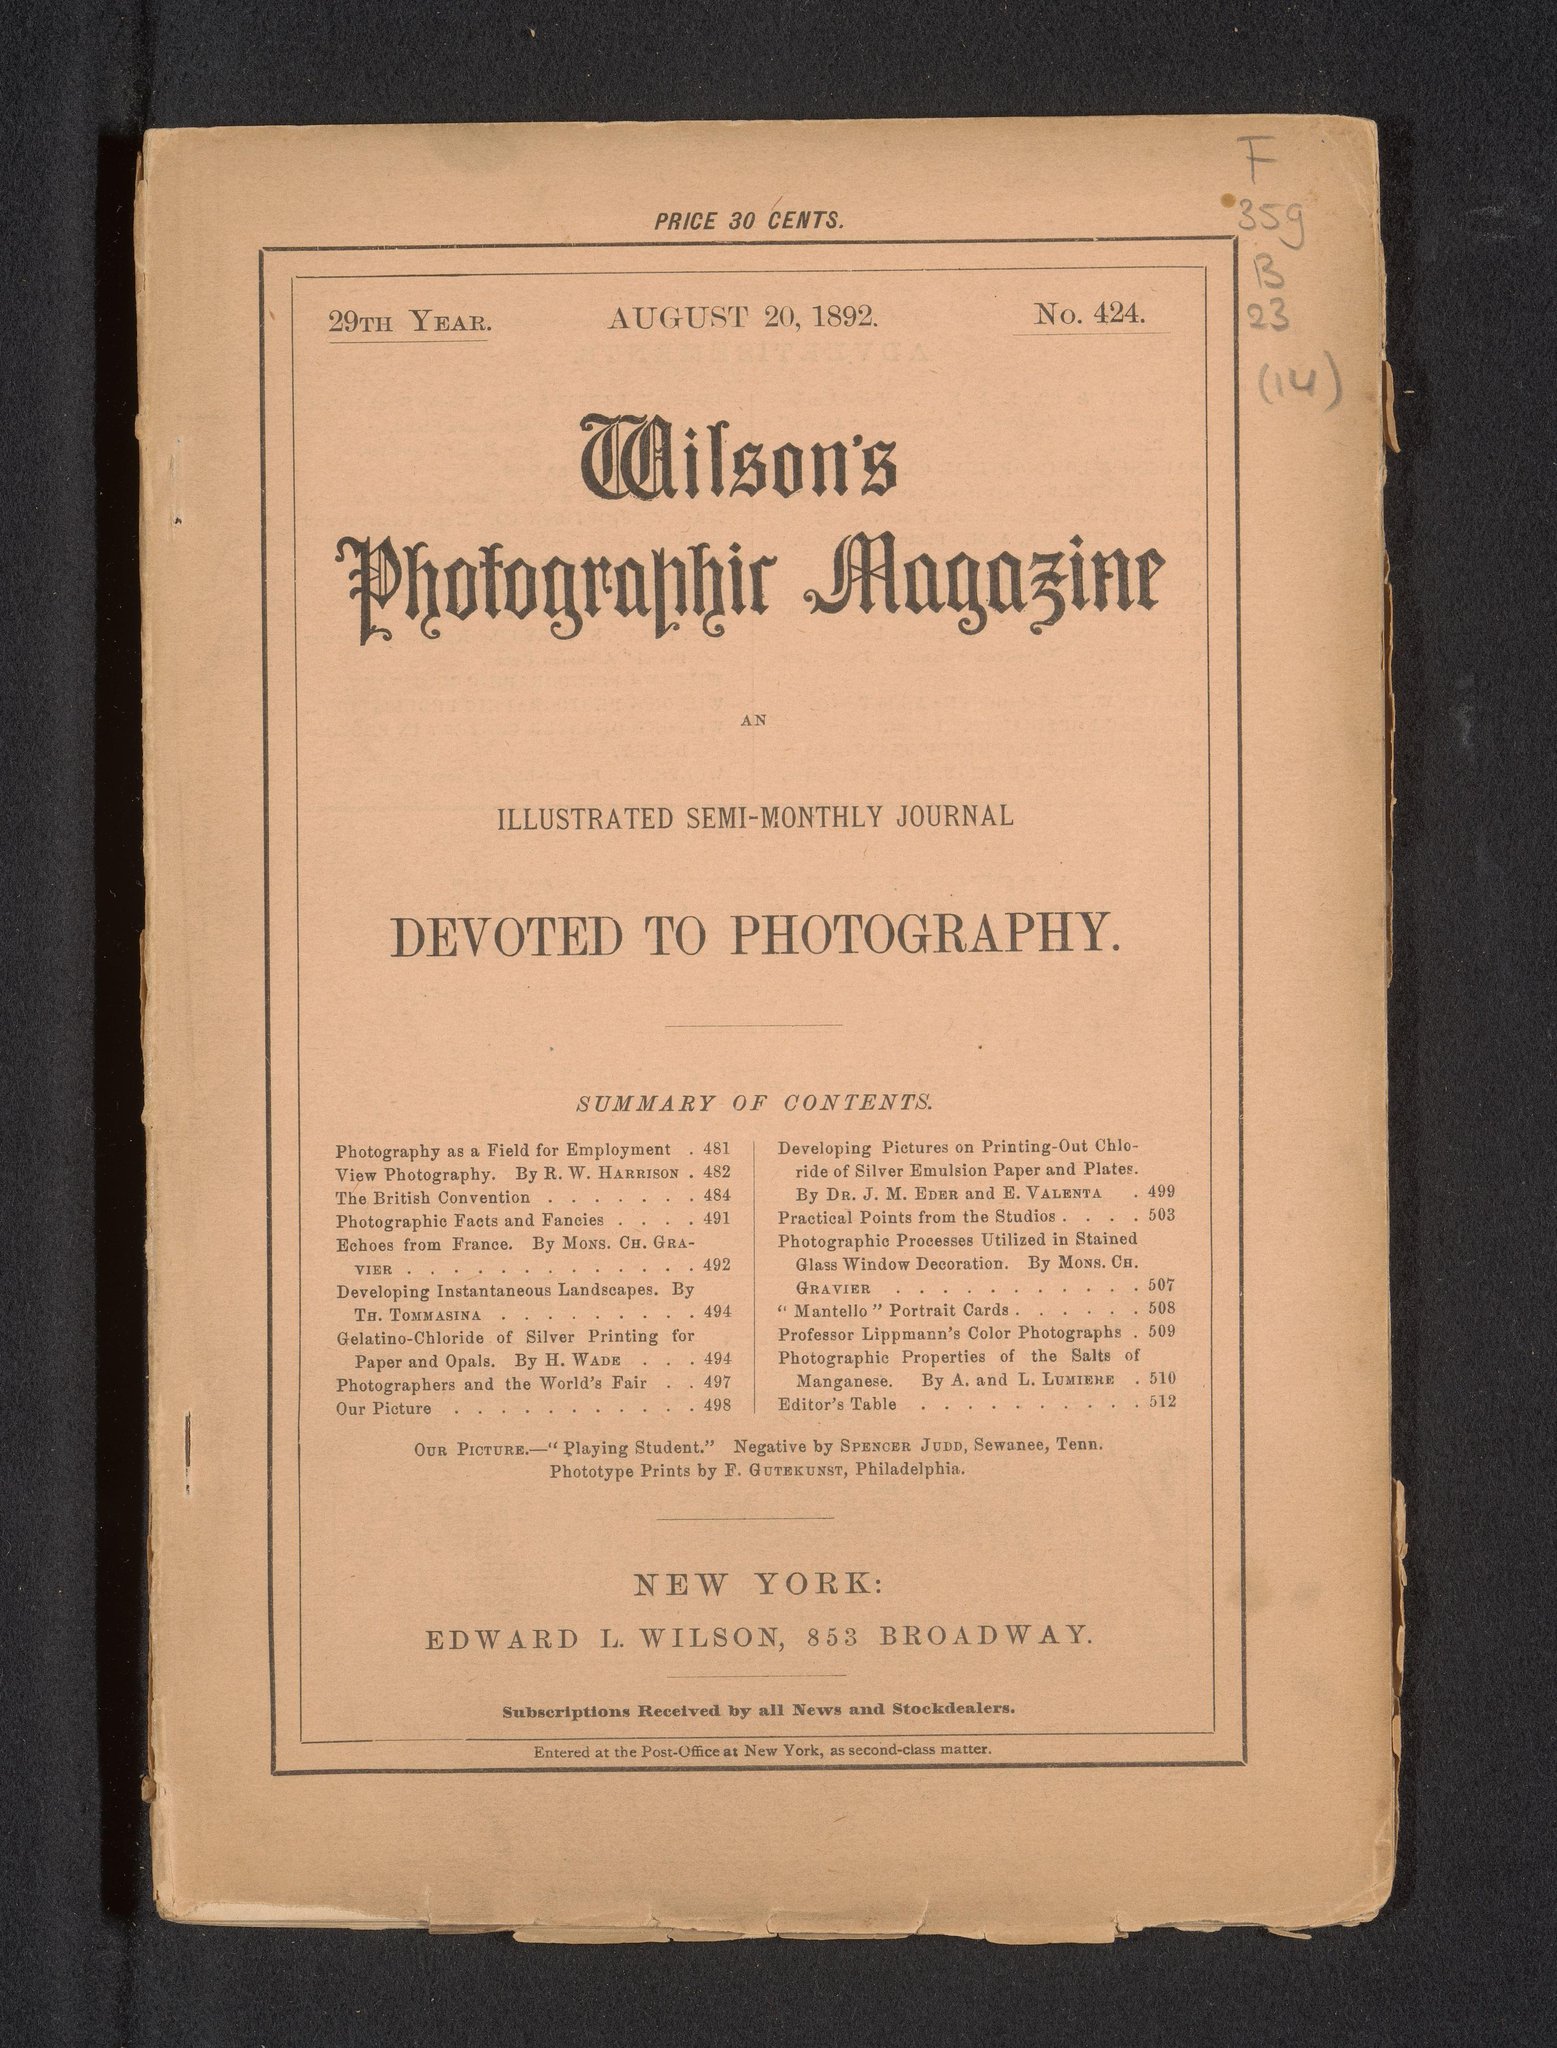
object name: magazine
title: Wilson's photographic magazine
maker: edward livingston wilson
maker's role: publisher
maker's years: 1838-1903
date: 1892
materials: paper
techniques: photograph, printing, engraving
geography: new york city